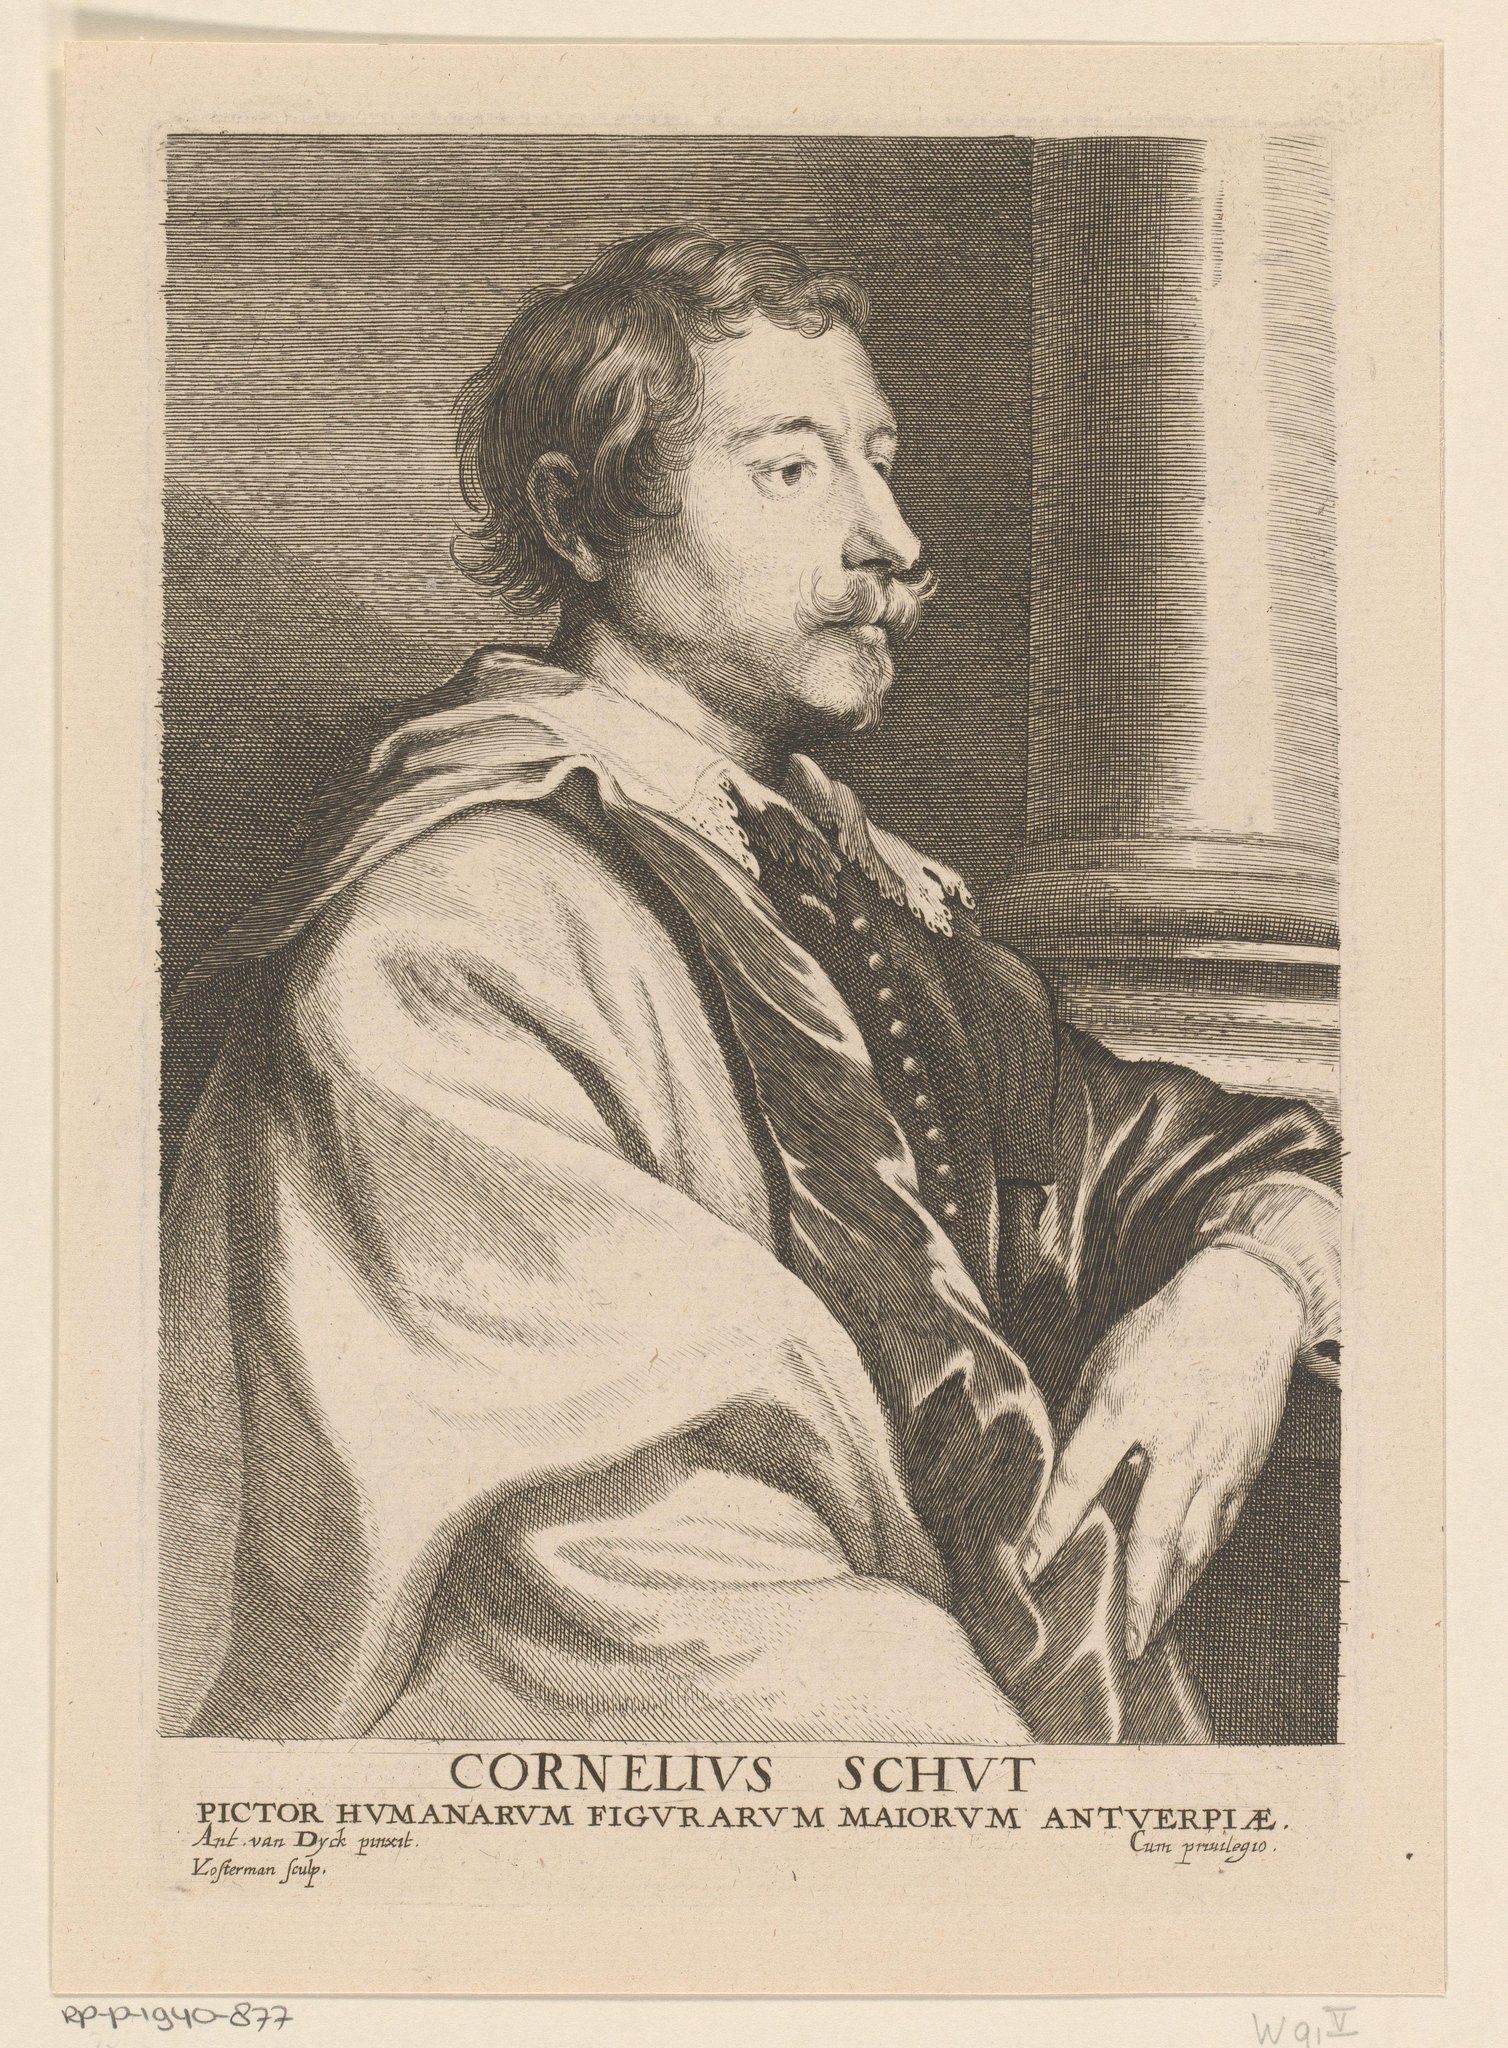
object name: print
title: Iconographie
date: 1646-1675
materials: paper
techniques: engraving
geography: antwerp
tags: antwerp, print maker, draughtsman, cornelis schut (i), historical persons, portrait, self-portrait of artist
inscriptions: collector's mark: Lugt 2760, collector's mark: 2166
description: Prent waarschijnlijk uit: Icones principum, virorum doctorum, pictorum, chalcographorum, statuariorum (...). Antwerpen: Gillis Hendricx, [1645-1646].